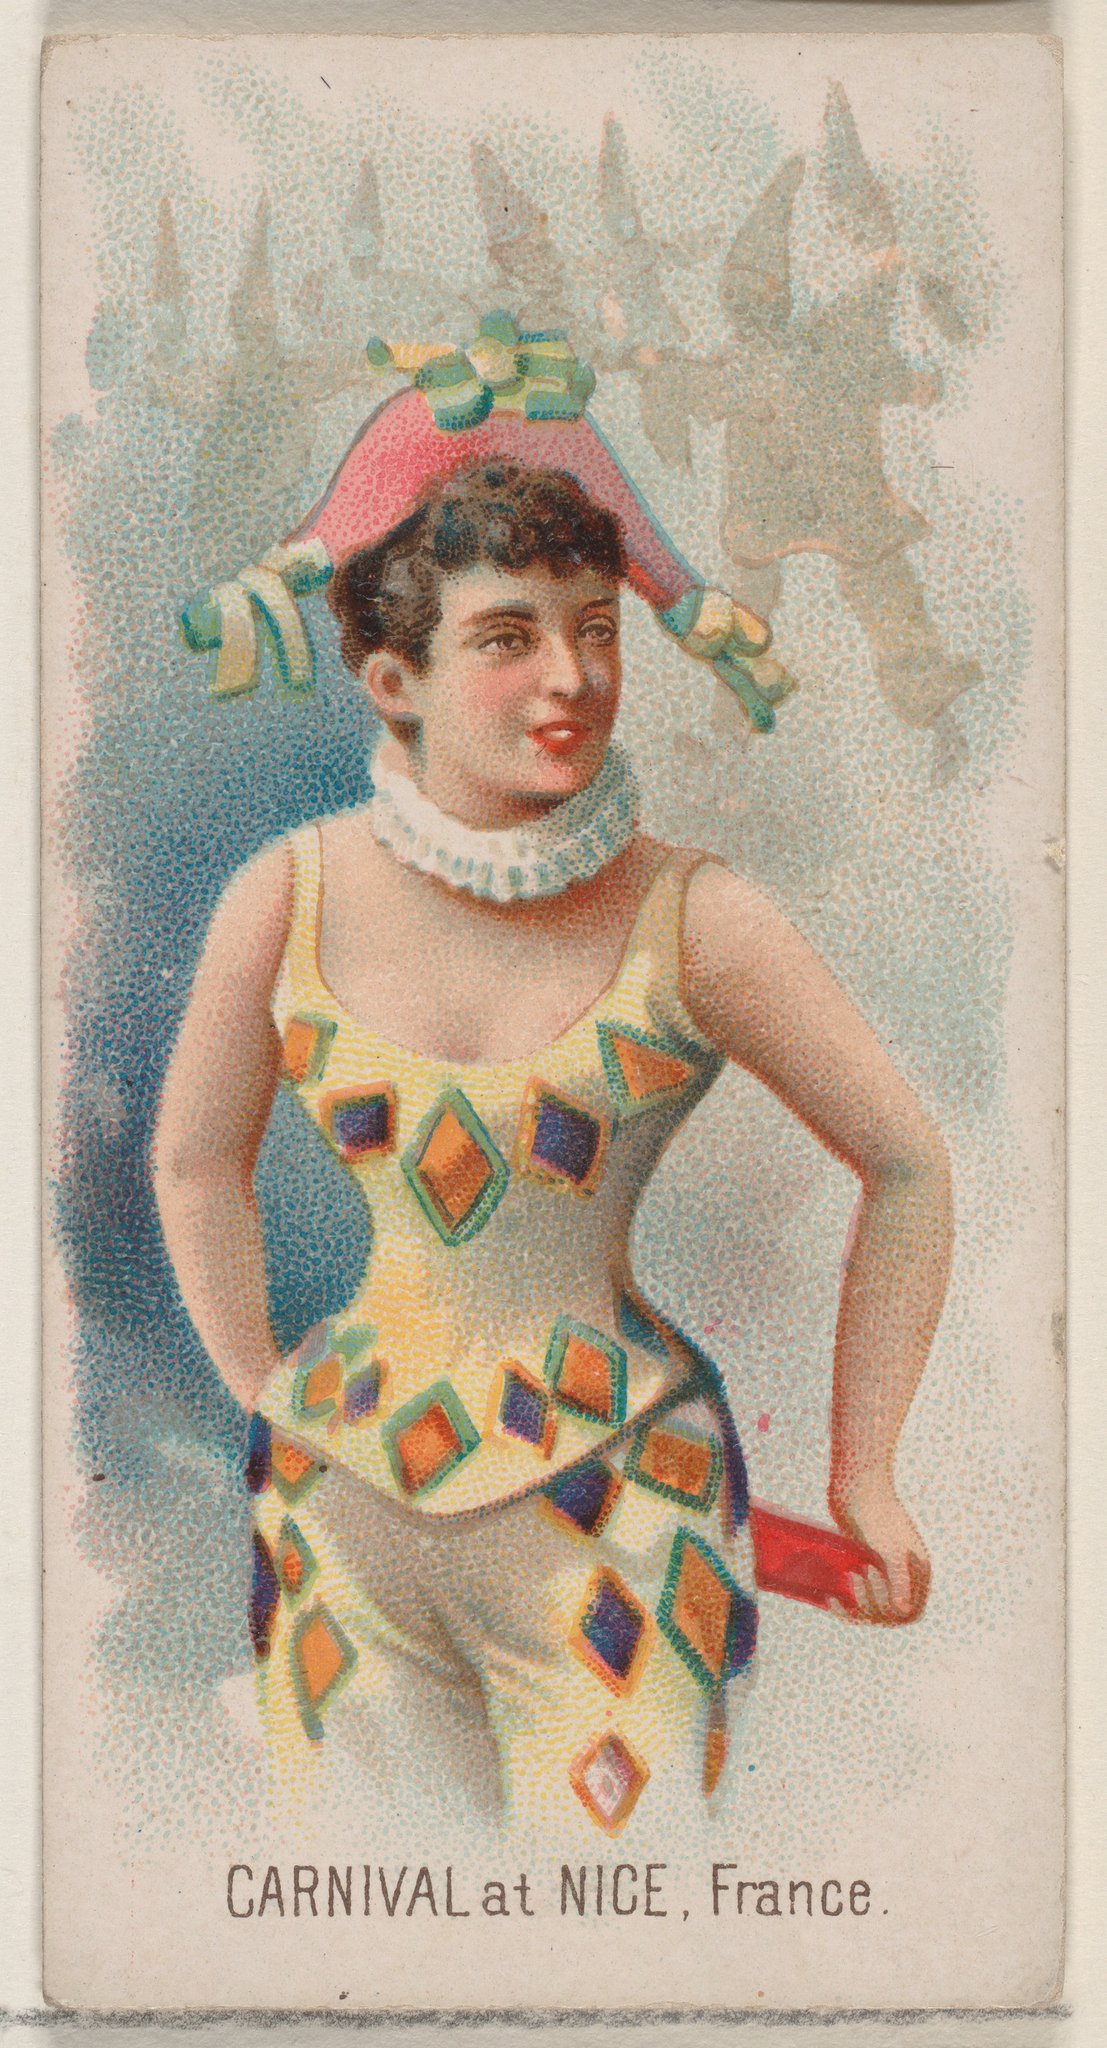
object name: print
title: Carnival at Nice, France, from the Holidays series (N80) for Duke brand cigarettes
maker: w. duke, sons & co.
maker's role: publisher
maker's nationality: american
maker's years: 1870-1920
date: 1890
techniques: color lithograph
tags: women